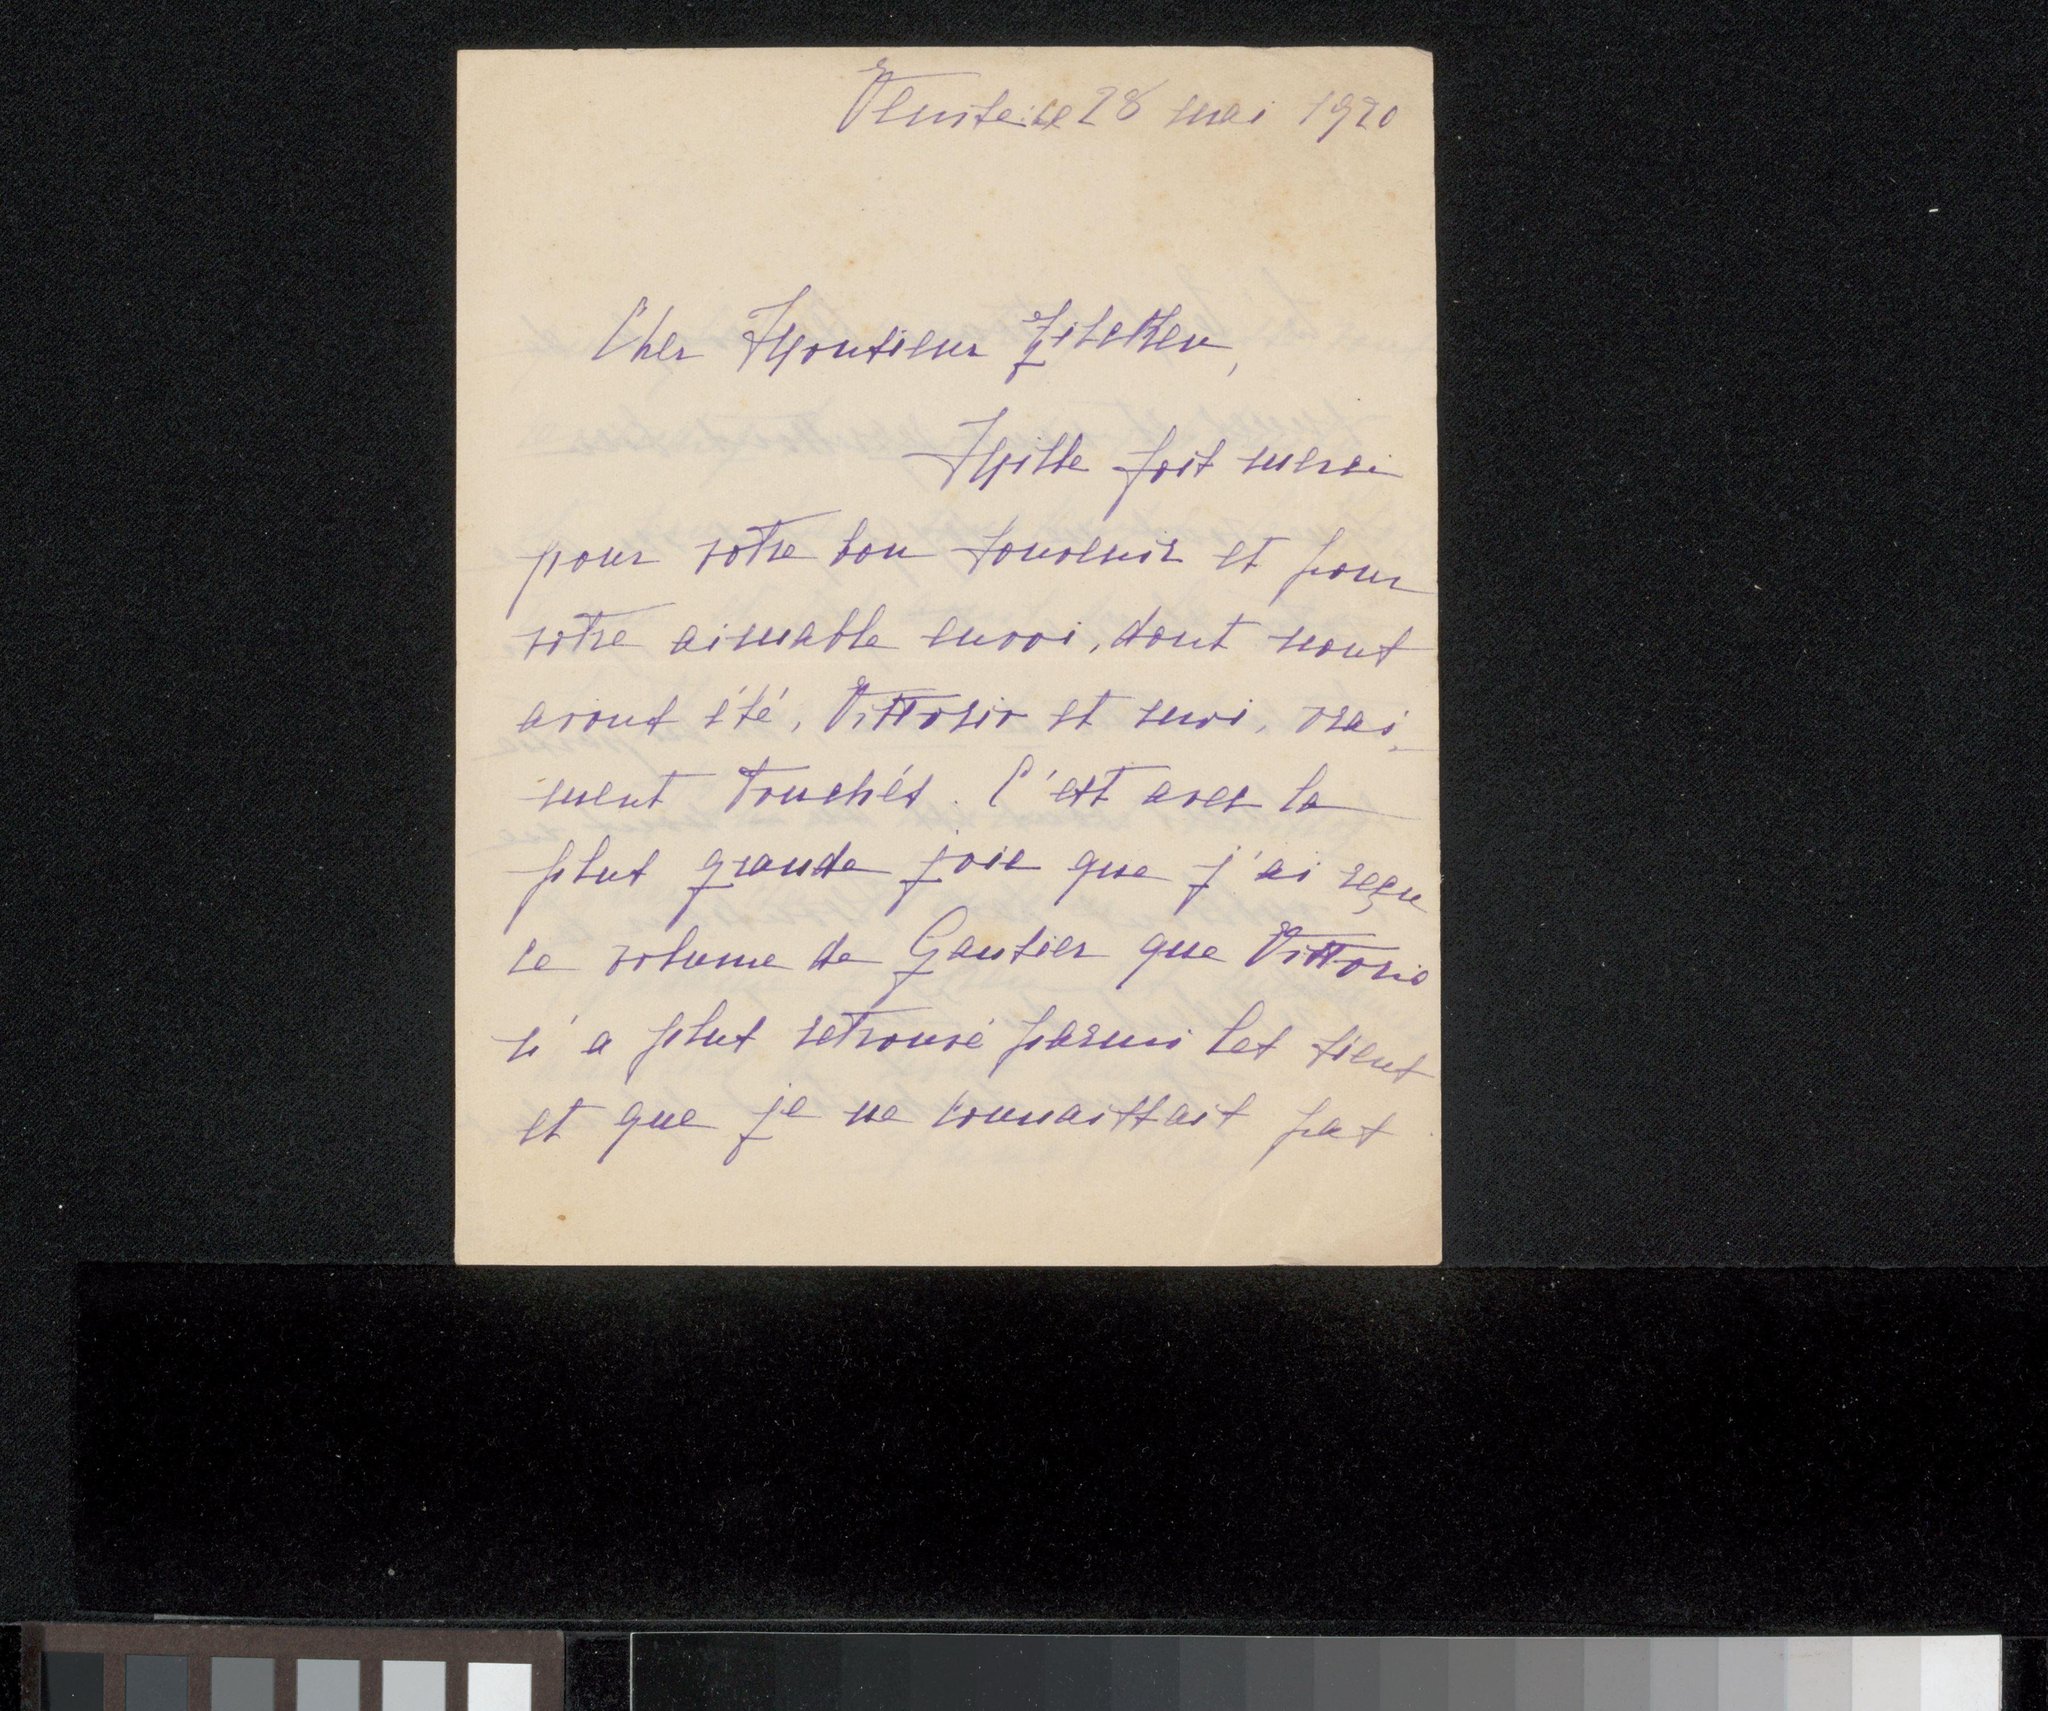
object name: letter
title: Brief aan Philip Zilcken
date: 1920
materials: ink, paper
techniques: pen, writing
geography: venice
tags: the hague, painter, draughtsman, philip zilcken, exhibition ~ art, rotterdam, venice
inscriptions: collector's mark: ‘RPK’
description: Brief bevat verso een brief van Vittorio Pica.